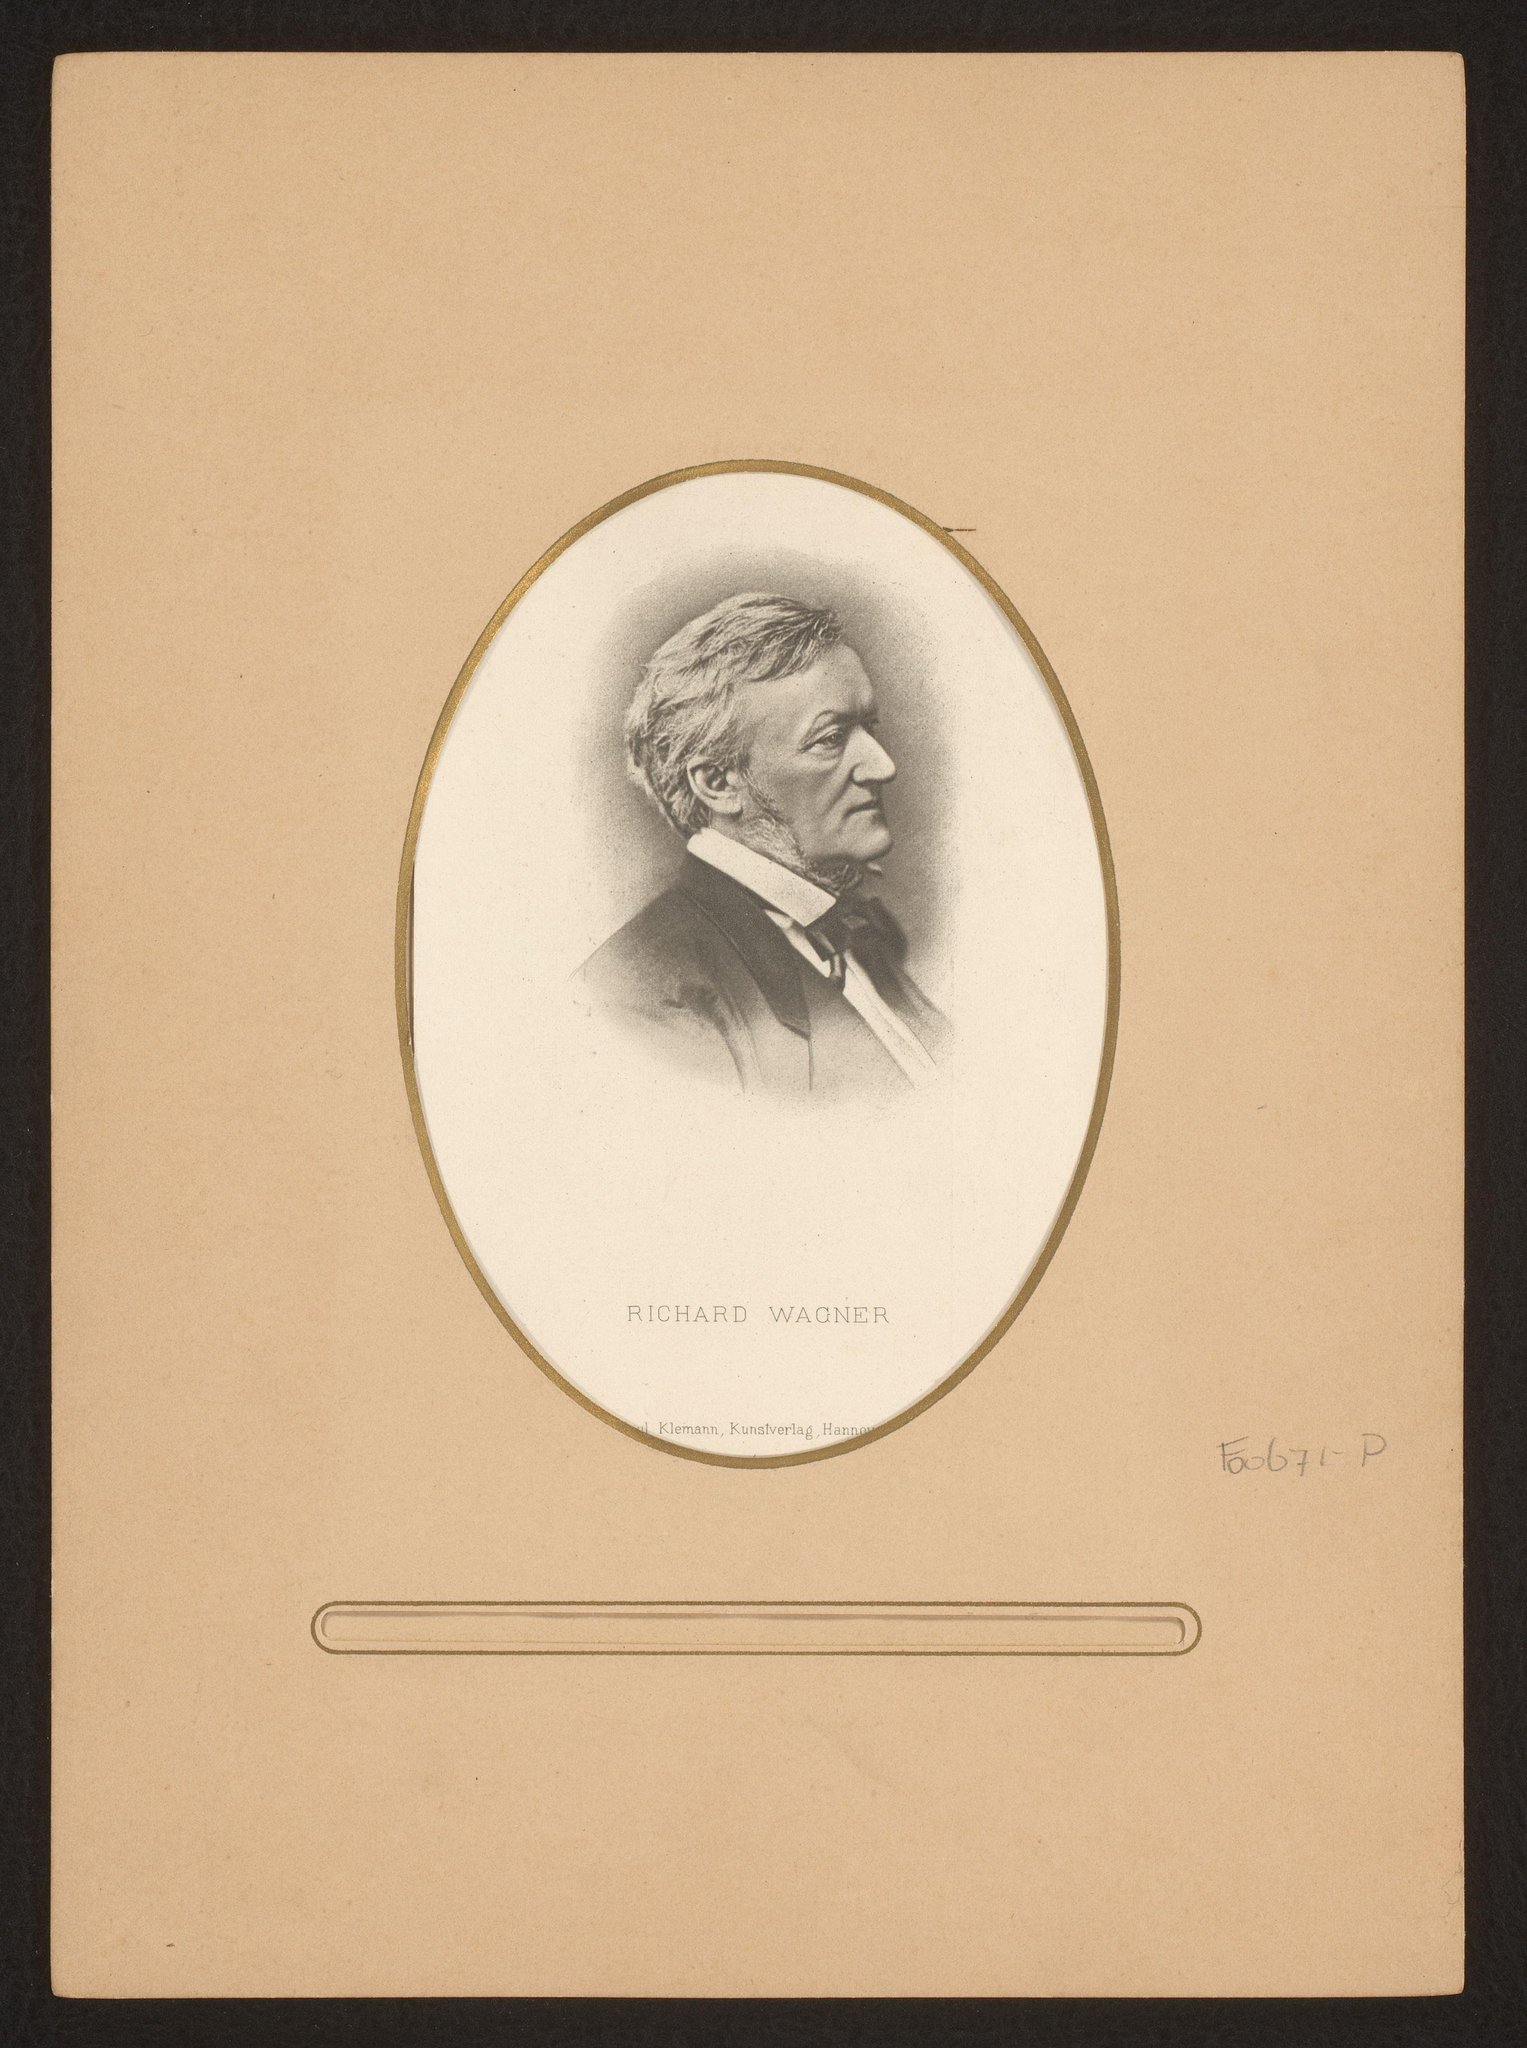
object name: ansichtkaart, prentbriefkaart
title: Reproductie van een portret van Richard Wagner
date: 1870-1900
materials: paper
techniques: rotogravure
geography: hannover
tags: richard wagner, historical persons, portrait of composer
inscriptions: inscription: ‘Richard Wagner/ Paul Klemann, Kunstverlag, Hannover./ 4.’